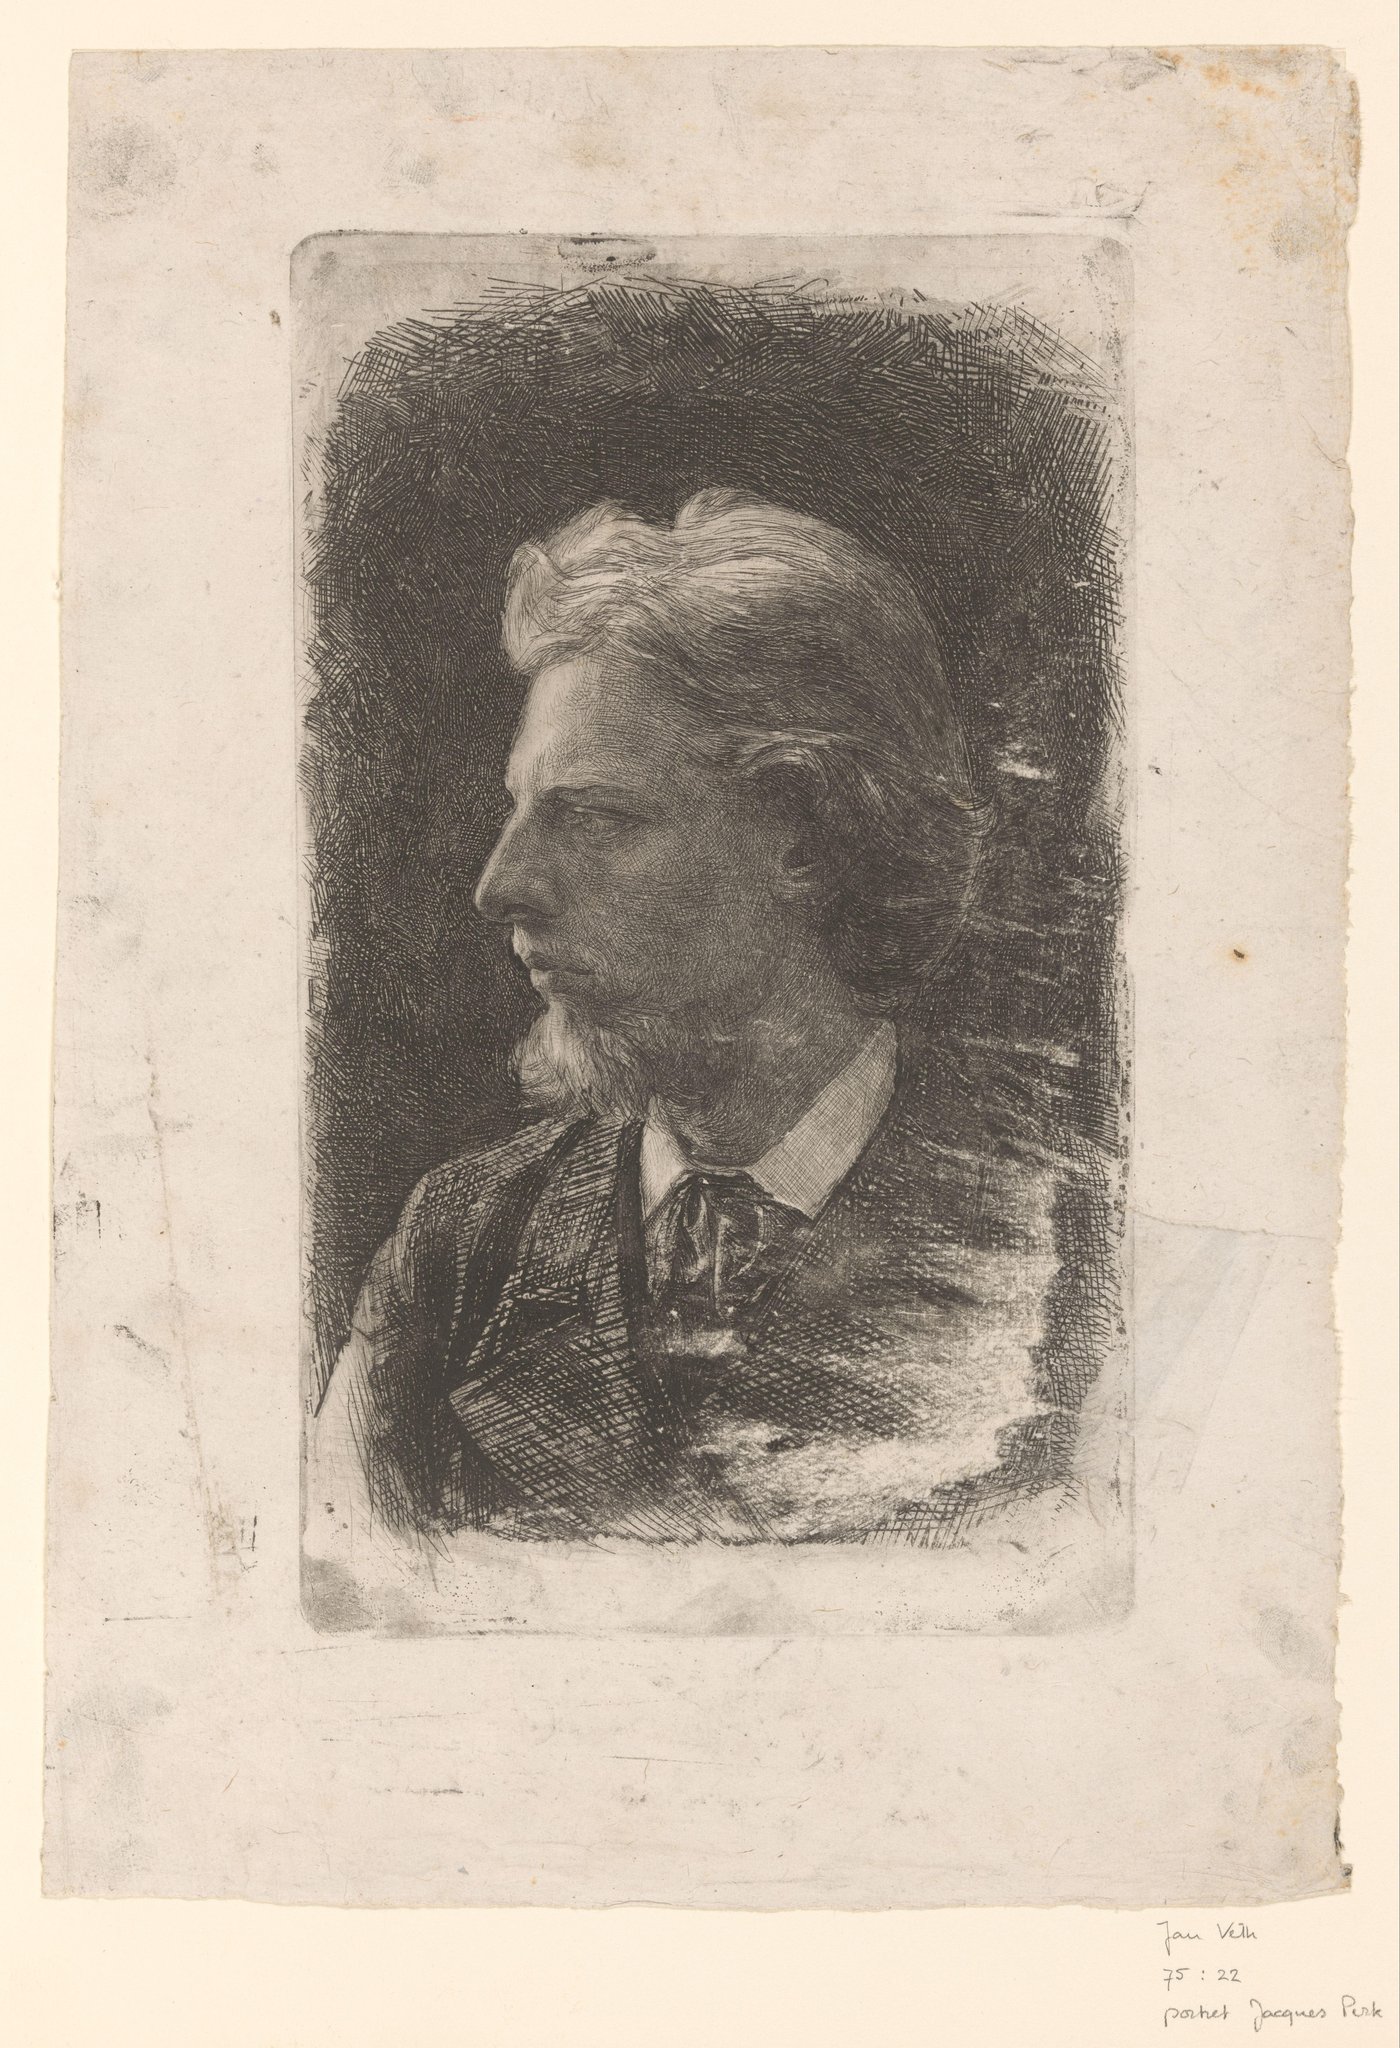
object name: print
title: Portret van Jacques Perk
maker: jan veth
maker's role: designer, draughtsman, painter, print maker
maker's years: 1864-1925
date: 1887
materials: paper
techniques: etching, intaglio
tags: jacques perk, historical persons, writer, poet, author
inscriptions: collector's mark: Lugt 2228